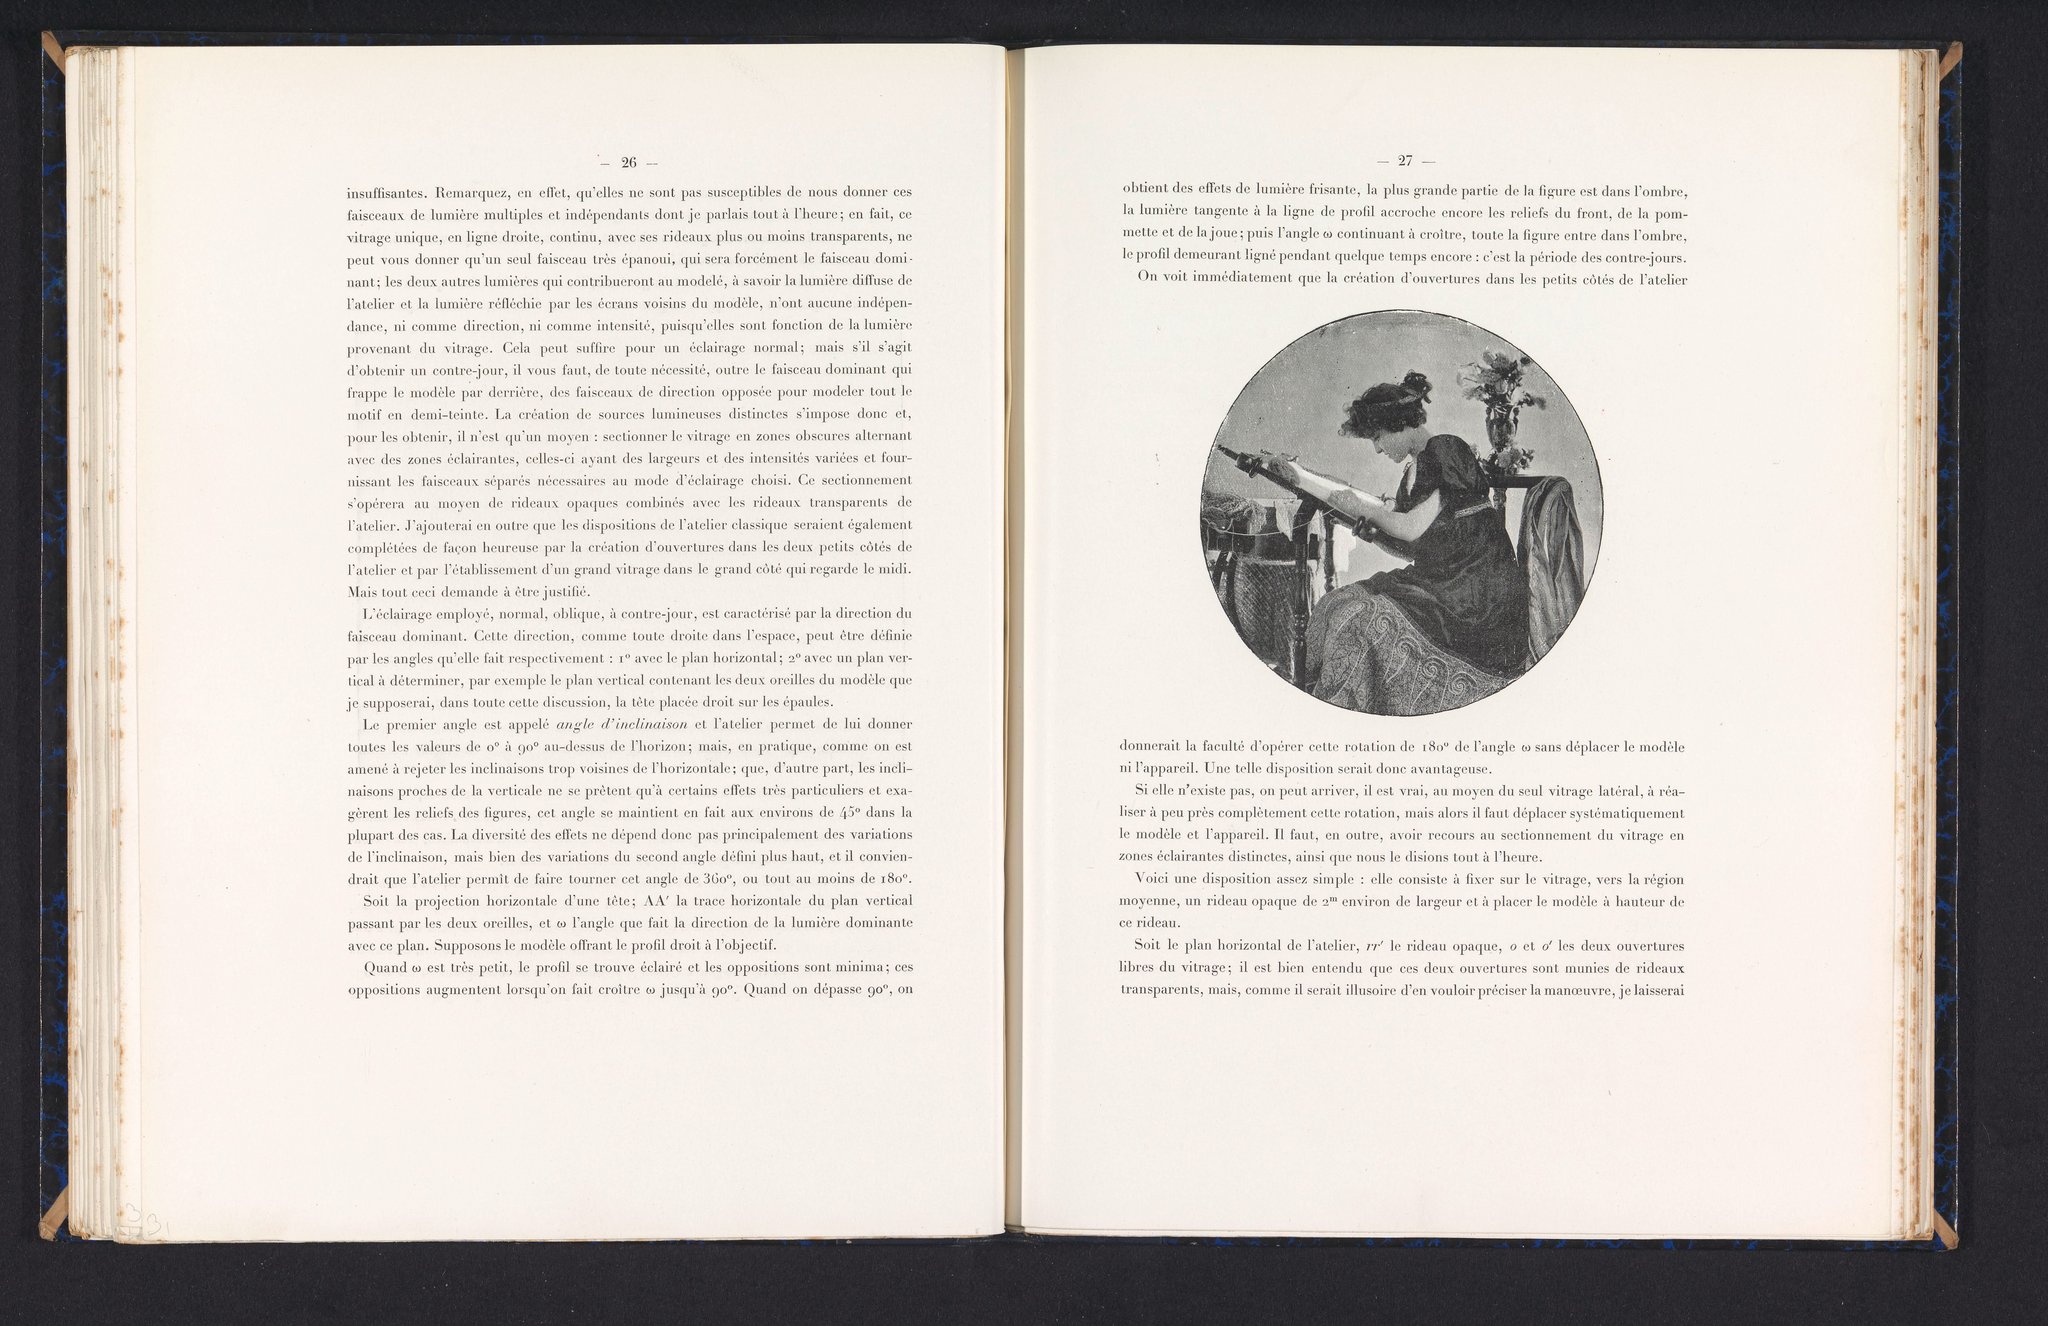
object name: page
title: Wevende vrouw in een interieur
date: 1886-1896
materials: paper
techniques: autotype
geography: france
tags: adult woman, weaving-loom, chair